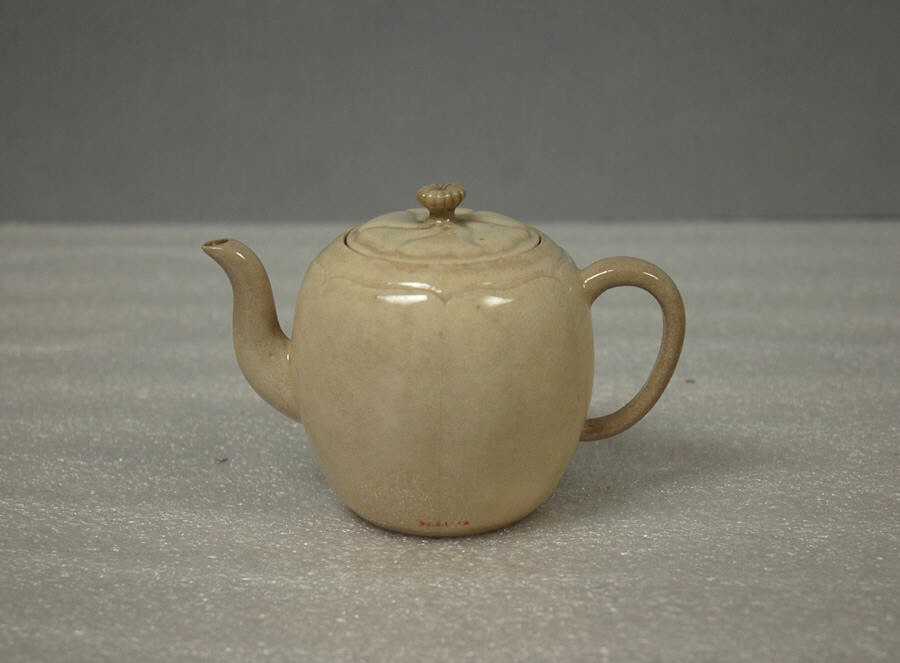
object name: teapot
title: Sencha Teapot (Kyūsu)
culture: japanese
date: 1801-1833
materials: glaze, stoneware